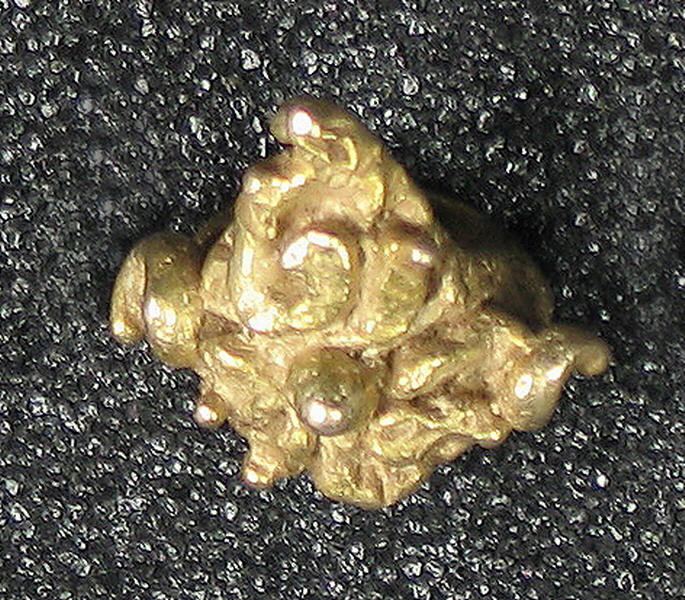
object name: earring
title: Earring with Foliate Decoration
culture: indonesian, central java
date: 701-1200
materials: gold